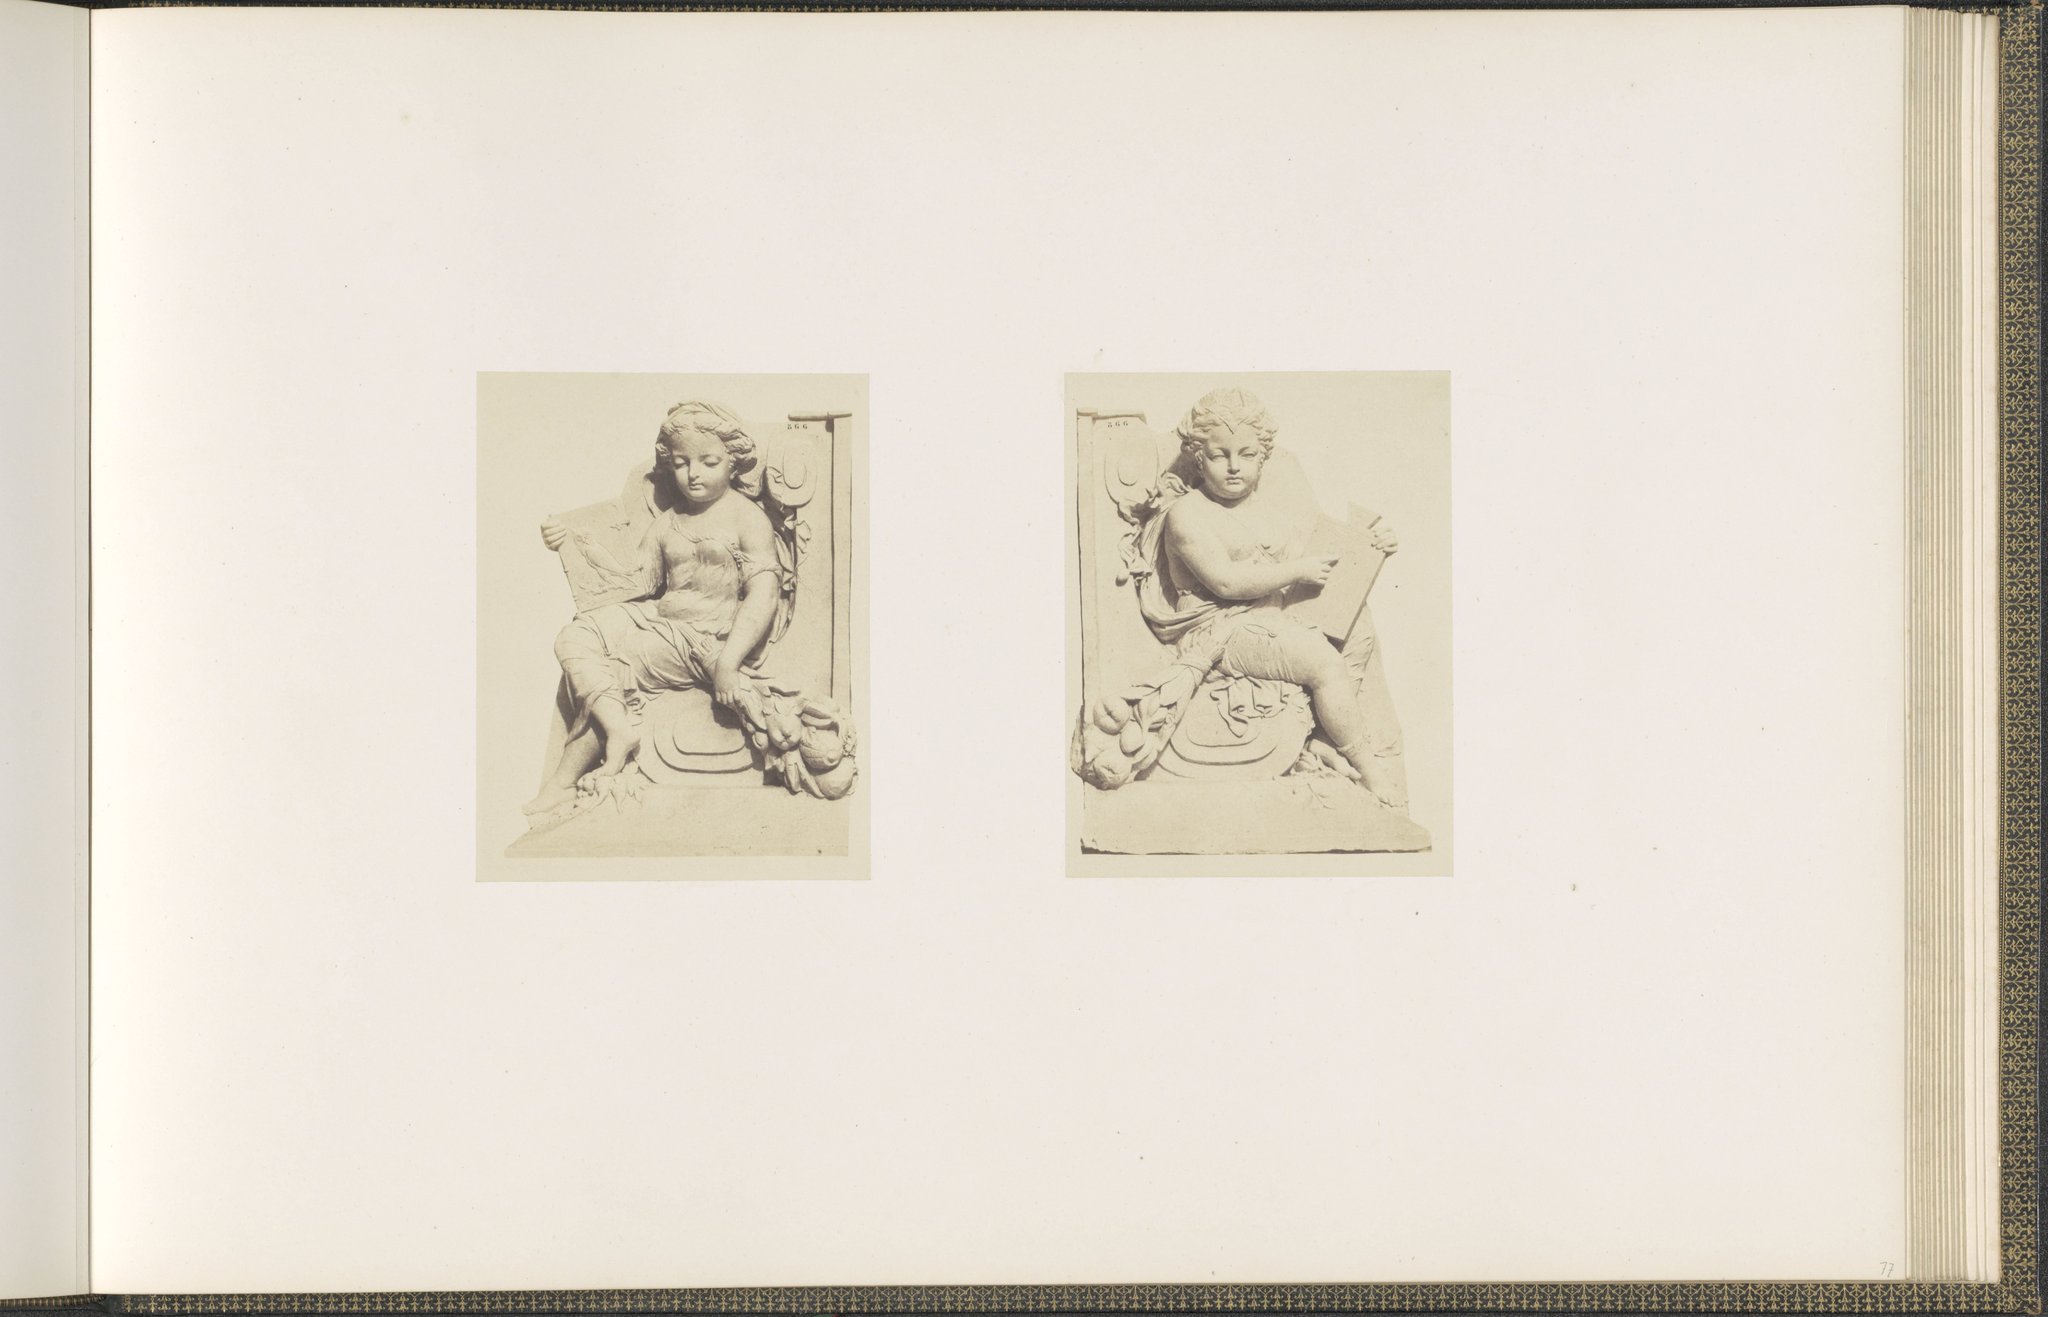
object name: album leaf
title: Gipsmodellen voor beeldhouwwerken op het Palais du Louvre: links "La Sagesse" en rechts "La Loi" door Pierre Edouard Charrier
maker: édouard denis baldus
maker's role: fotograaf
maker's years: 1813-1889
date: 1855-1857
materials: paper, photographic support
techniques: salted paper print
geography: paris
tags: piece of sculpture, reproduction of a piece of sculpture, permanent exhibition, museum, paris, tuileries palace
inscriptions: number: ‘866 (beide)’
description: Onderdeel van Réunion des Tuileries au Louvre 1852-1857, album 4.